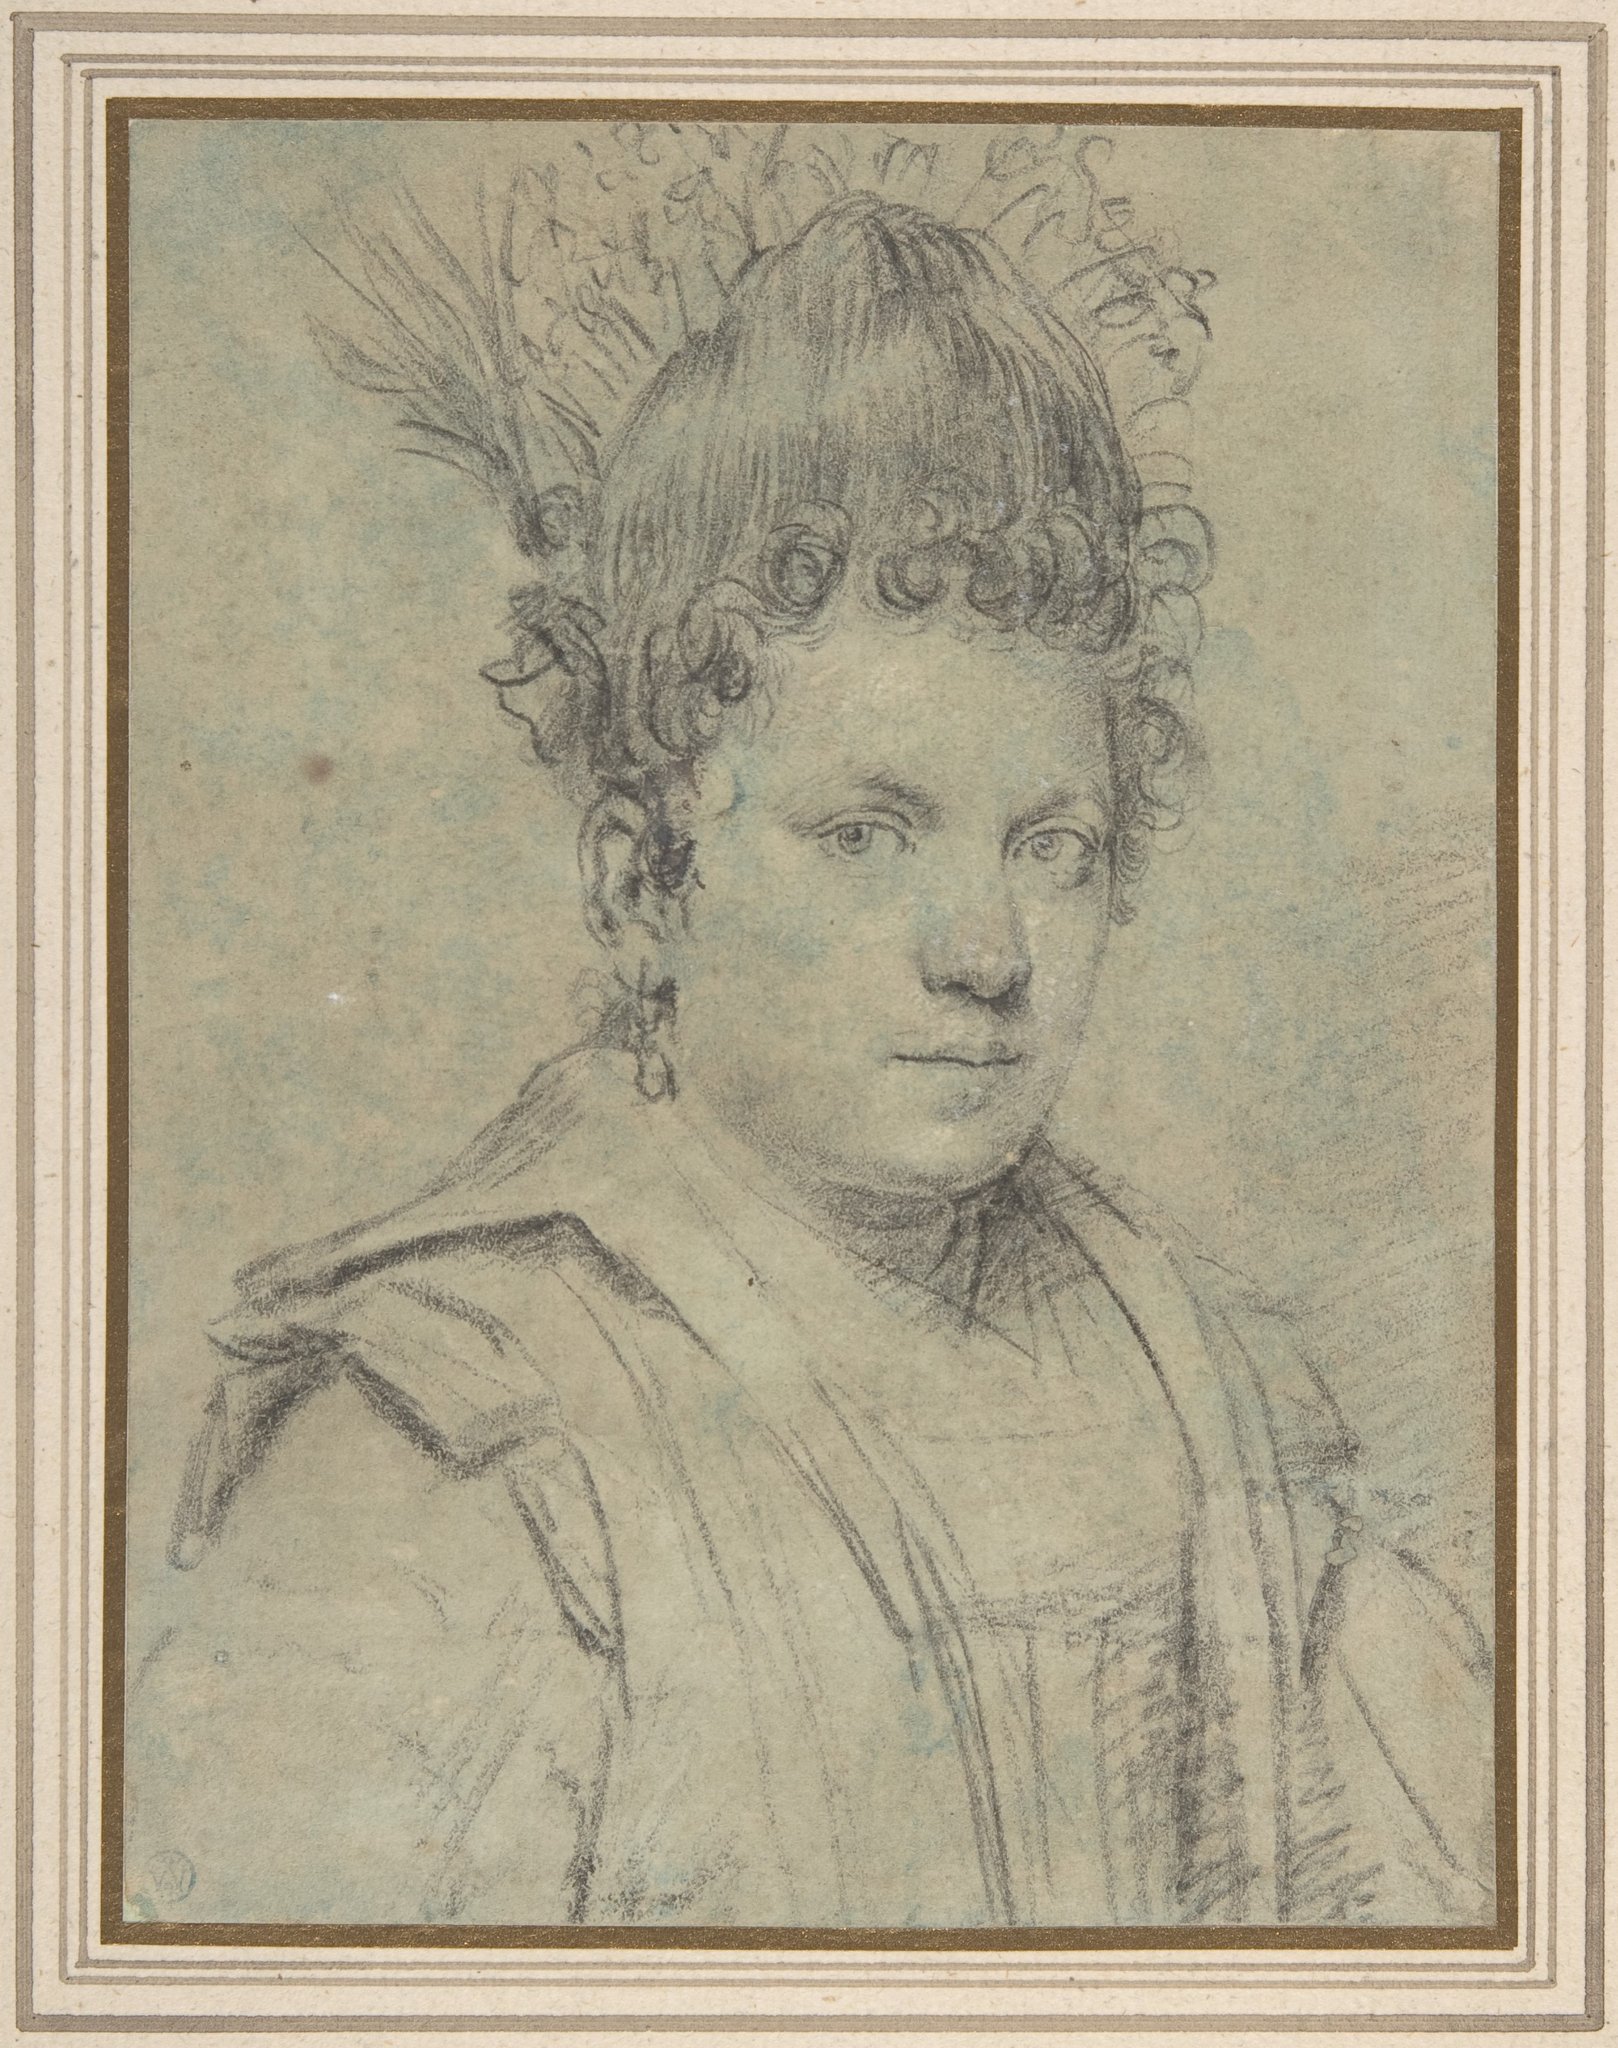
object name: drawing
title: Portrait of a Woman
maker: ottavio leoni (il padovano)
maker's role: artist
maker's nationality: italian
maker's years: 1578-1630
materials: chalk, paper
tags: portraits,women